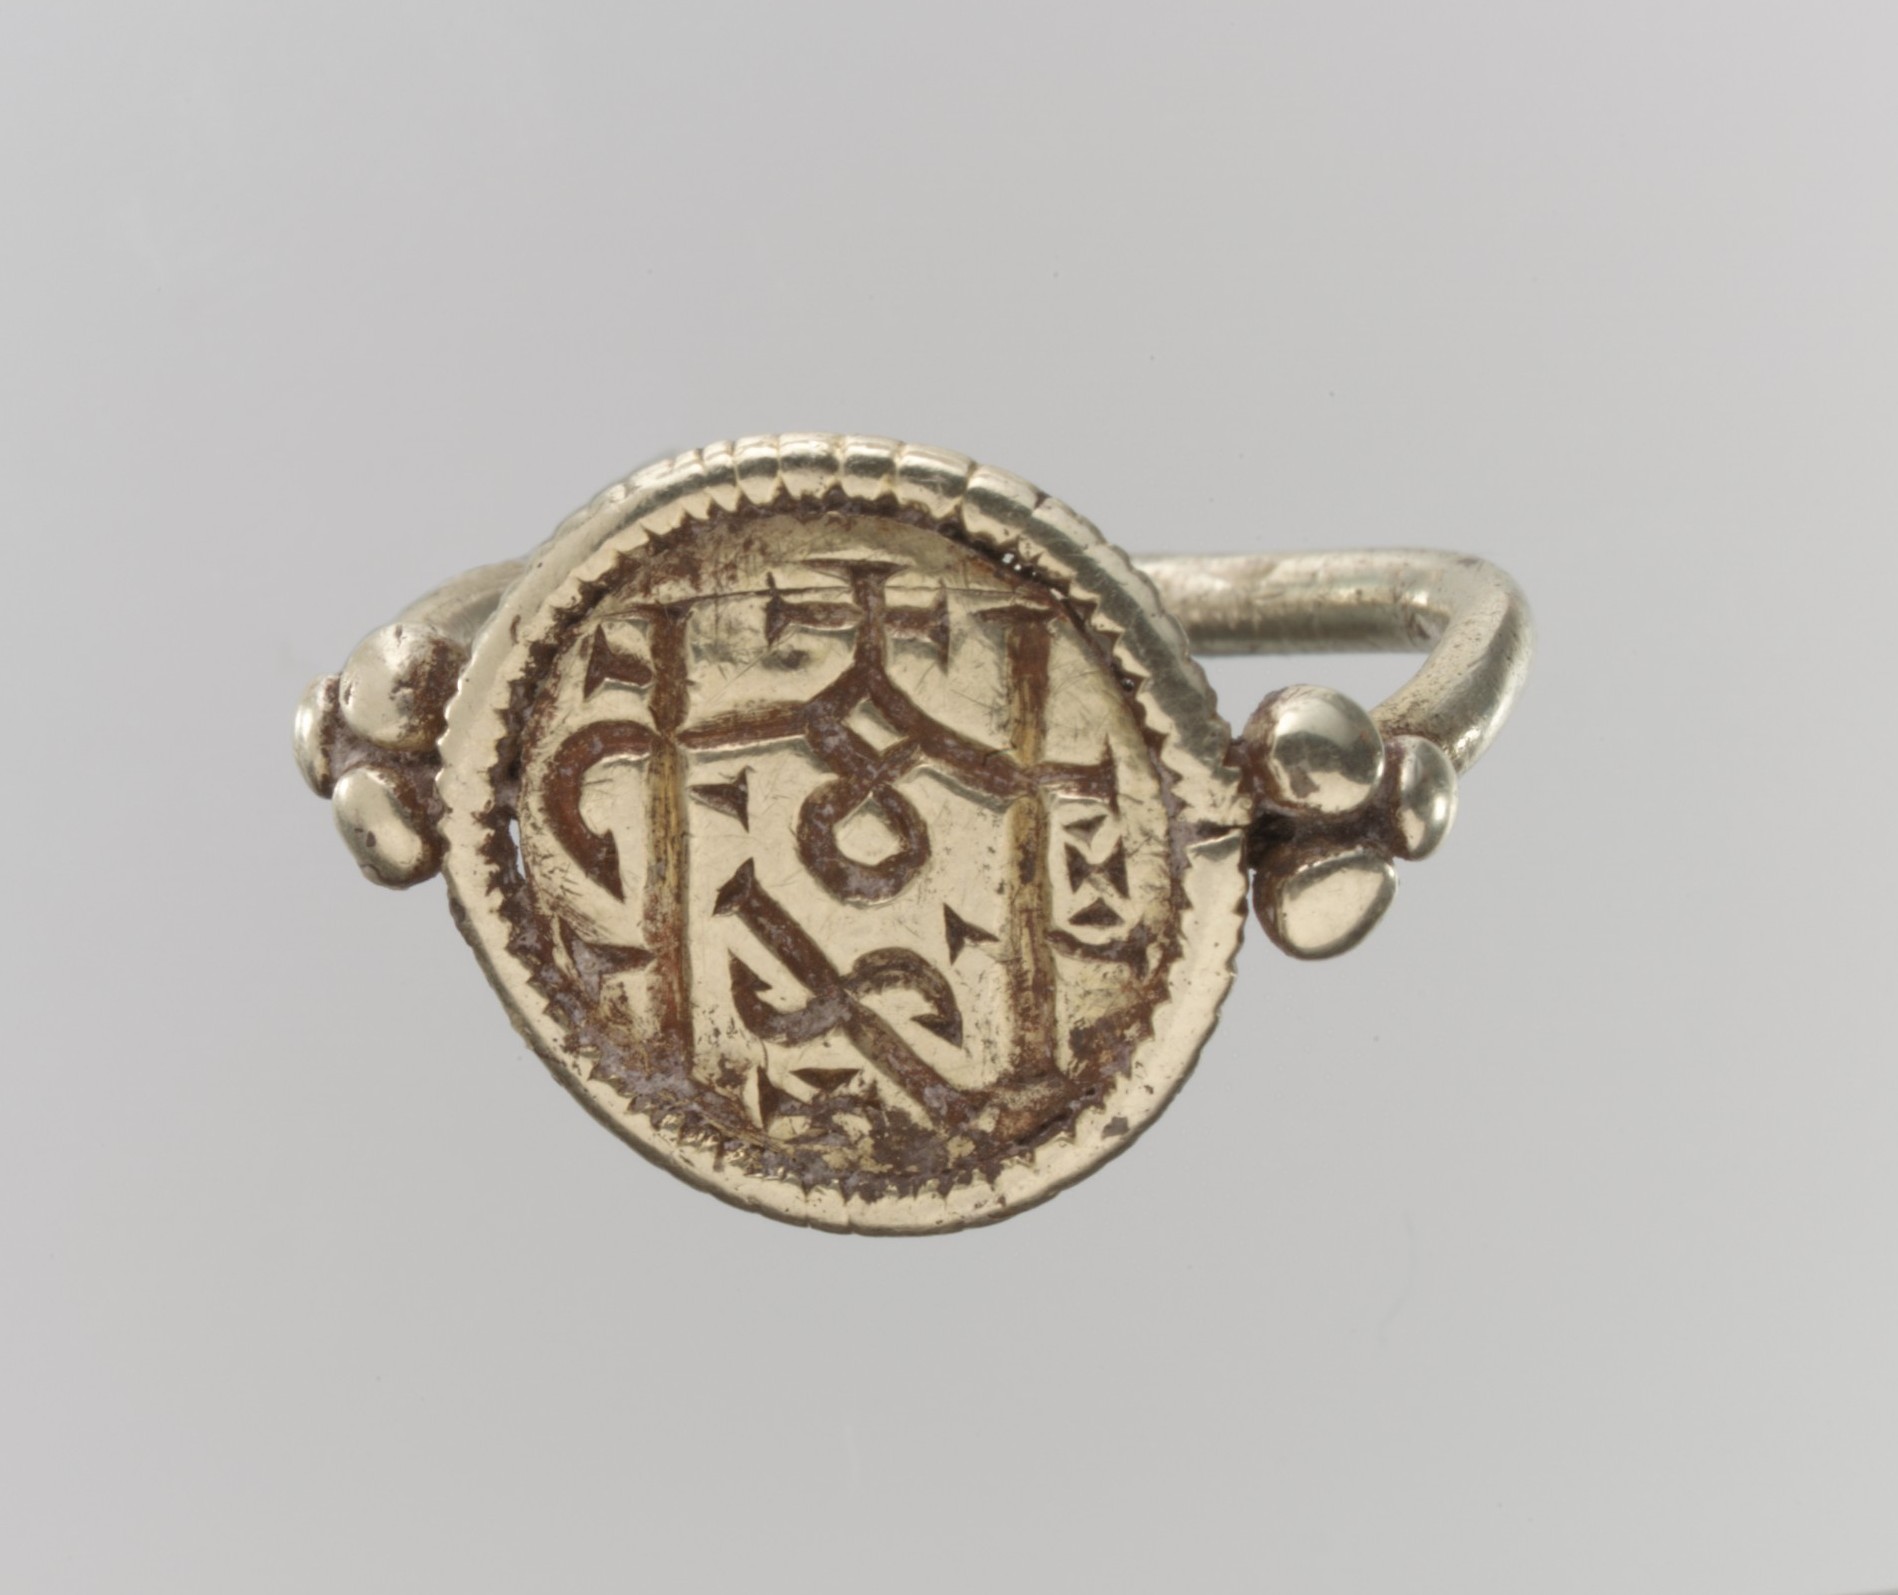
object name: ring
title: Electrum Signet Ring with Monogram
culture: frankish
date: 601-700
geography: northern france